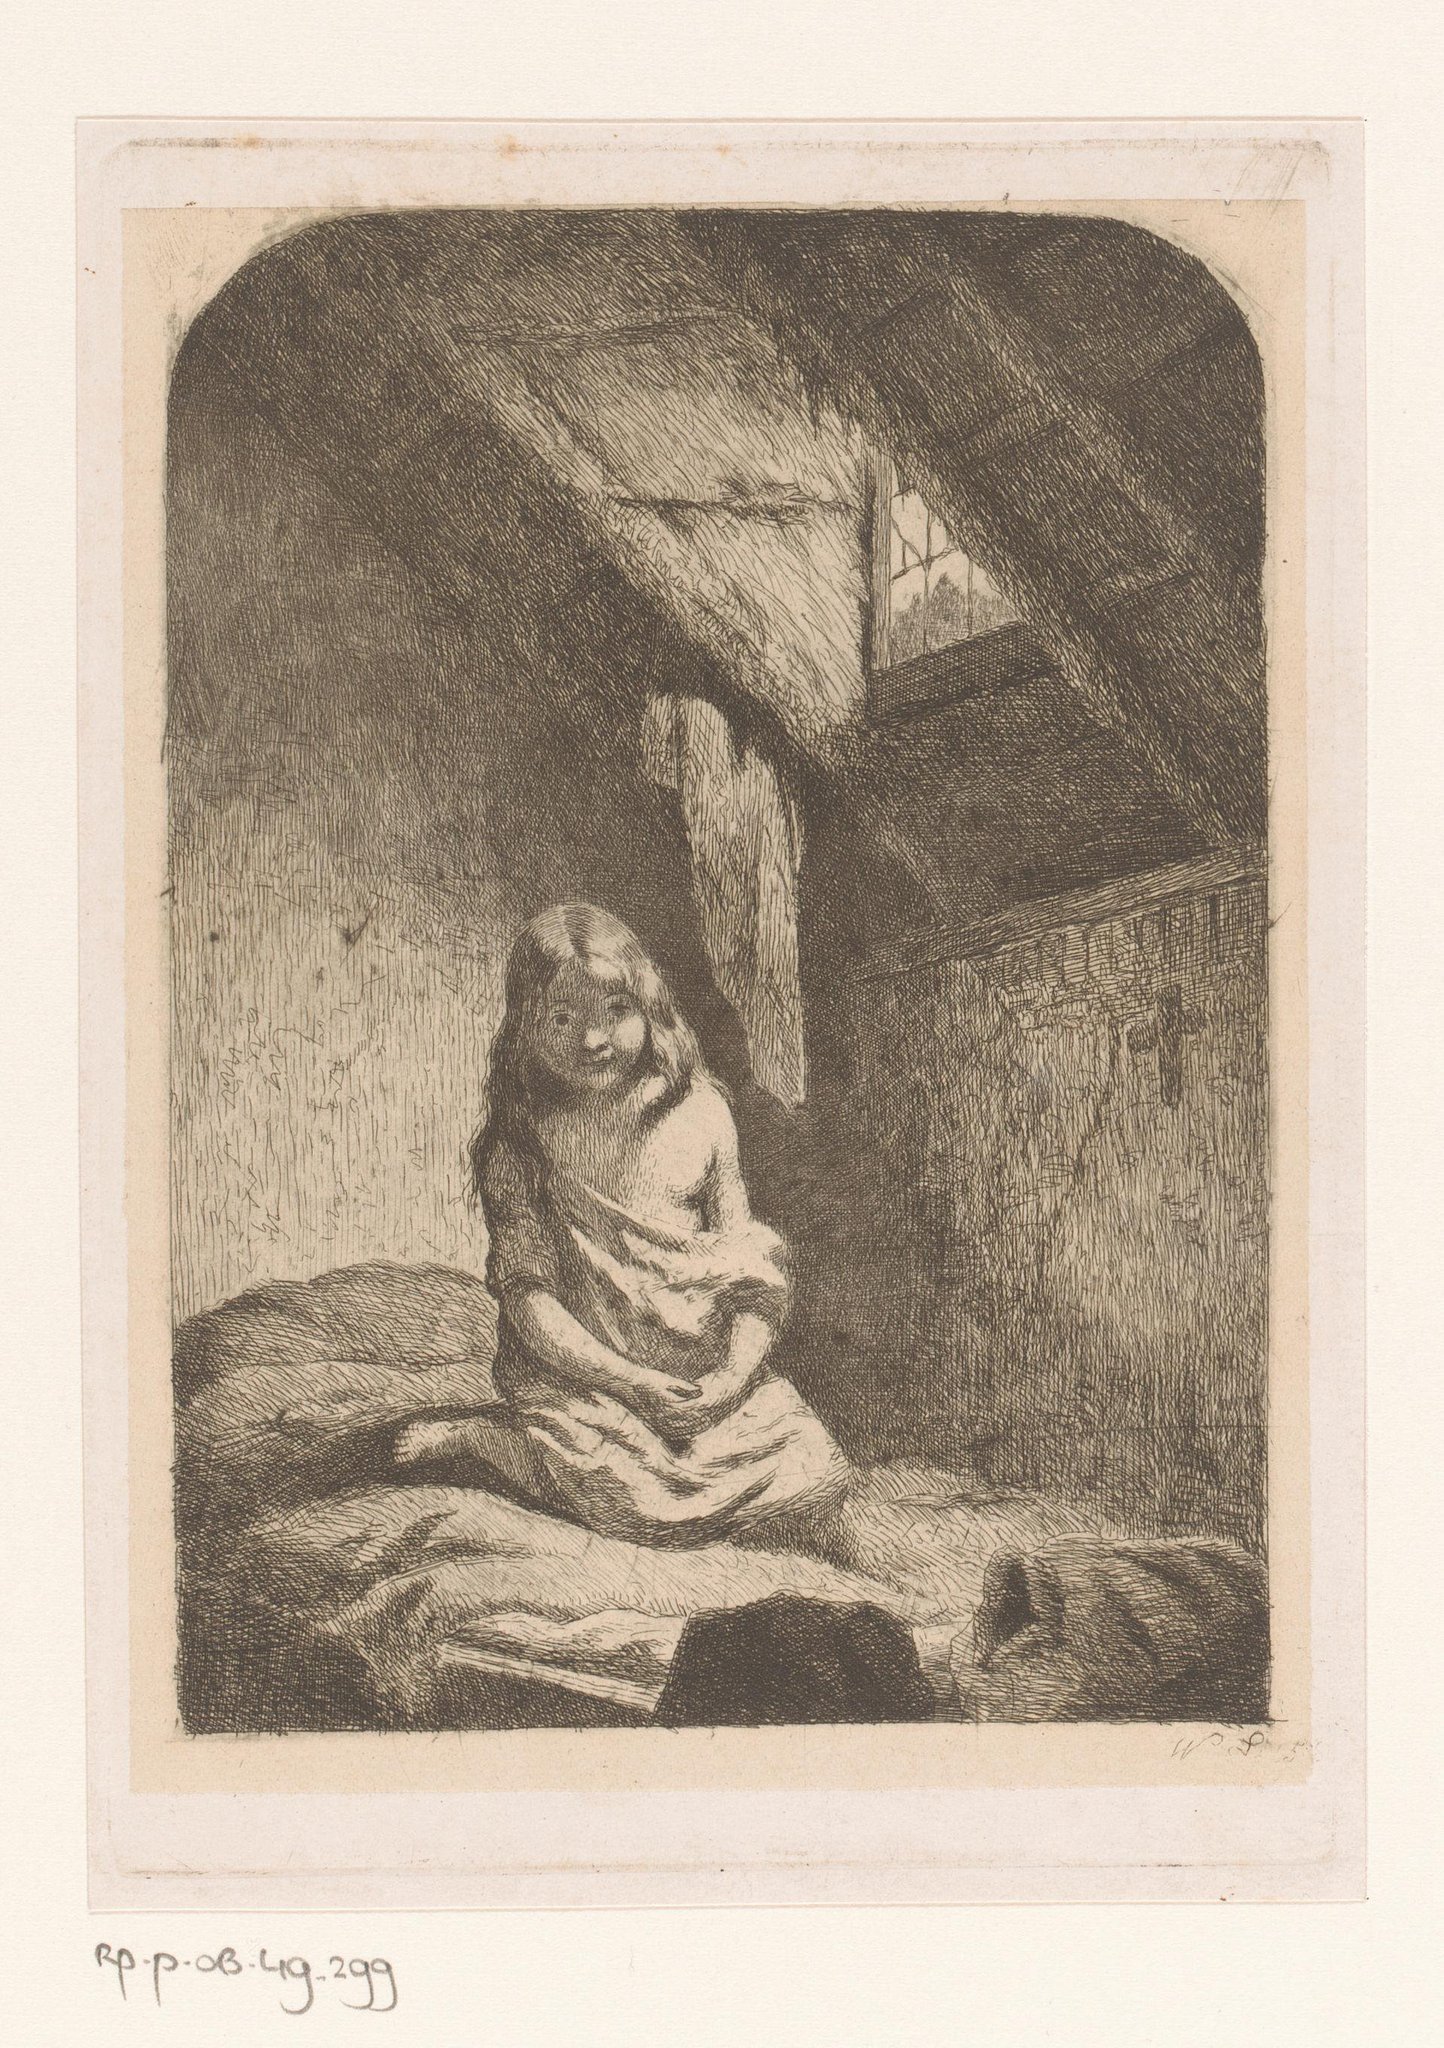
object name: print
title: Meisje op bed in een zolderkamer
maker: willem linnig (i)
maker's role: print maker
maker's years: 1819-1885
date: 1856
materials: paper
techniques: etching, intaglio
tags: bed, child (at home) - aa - girl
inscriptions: collector's mark: Lugt 2228